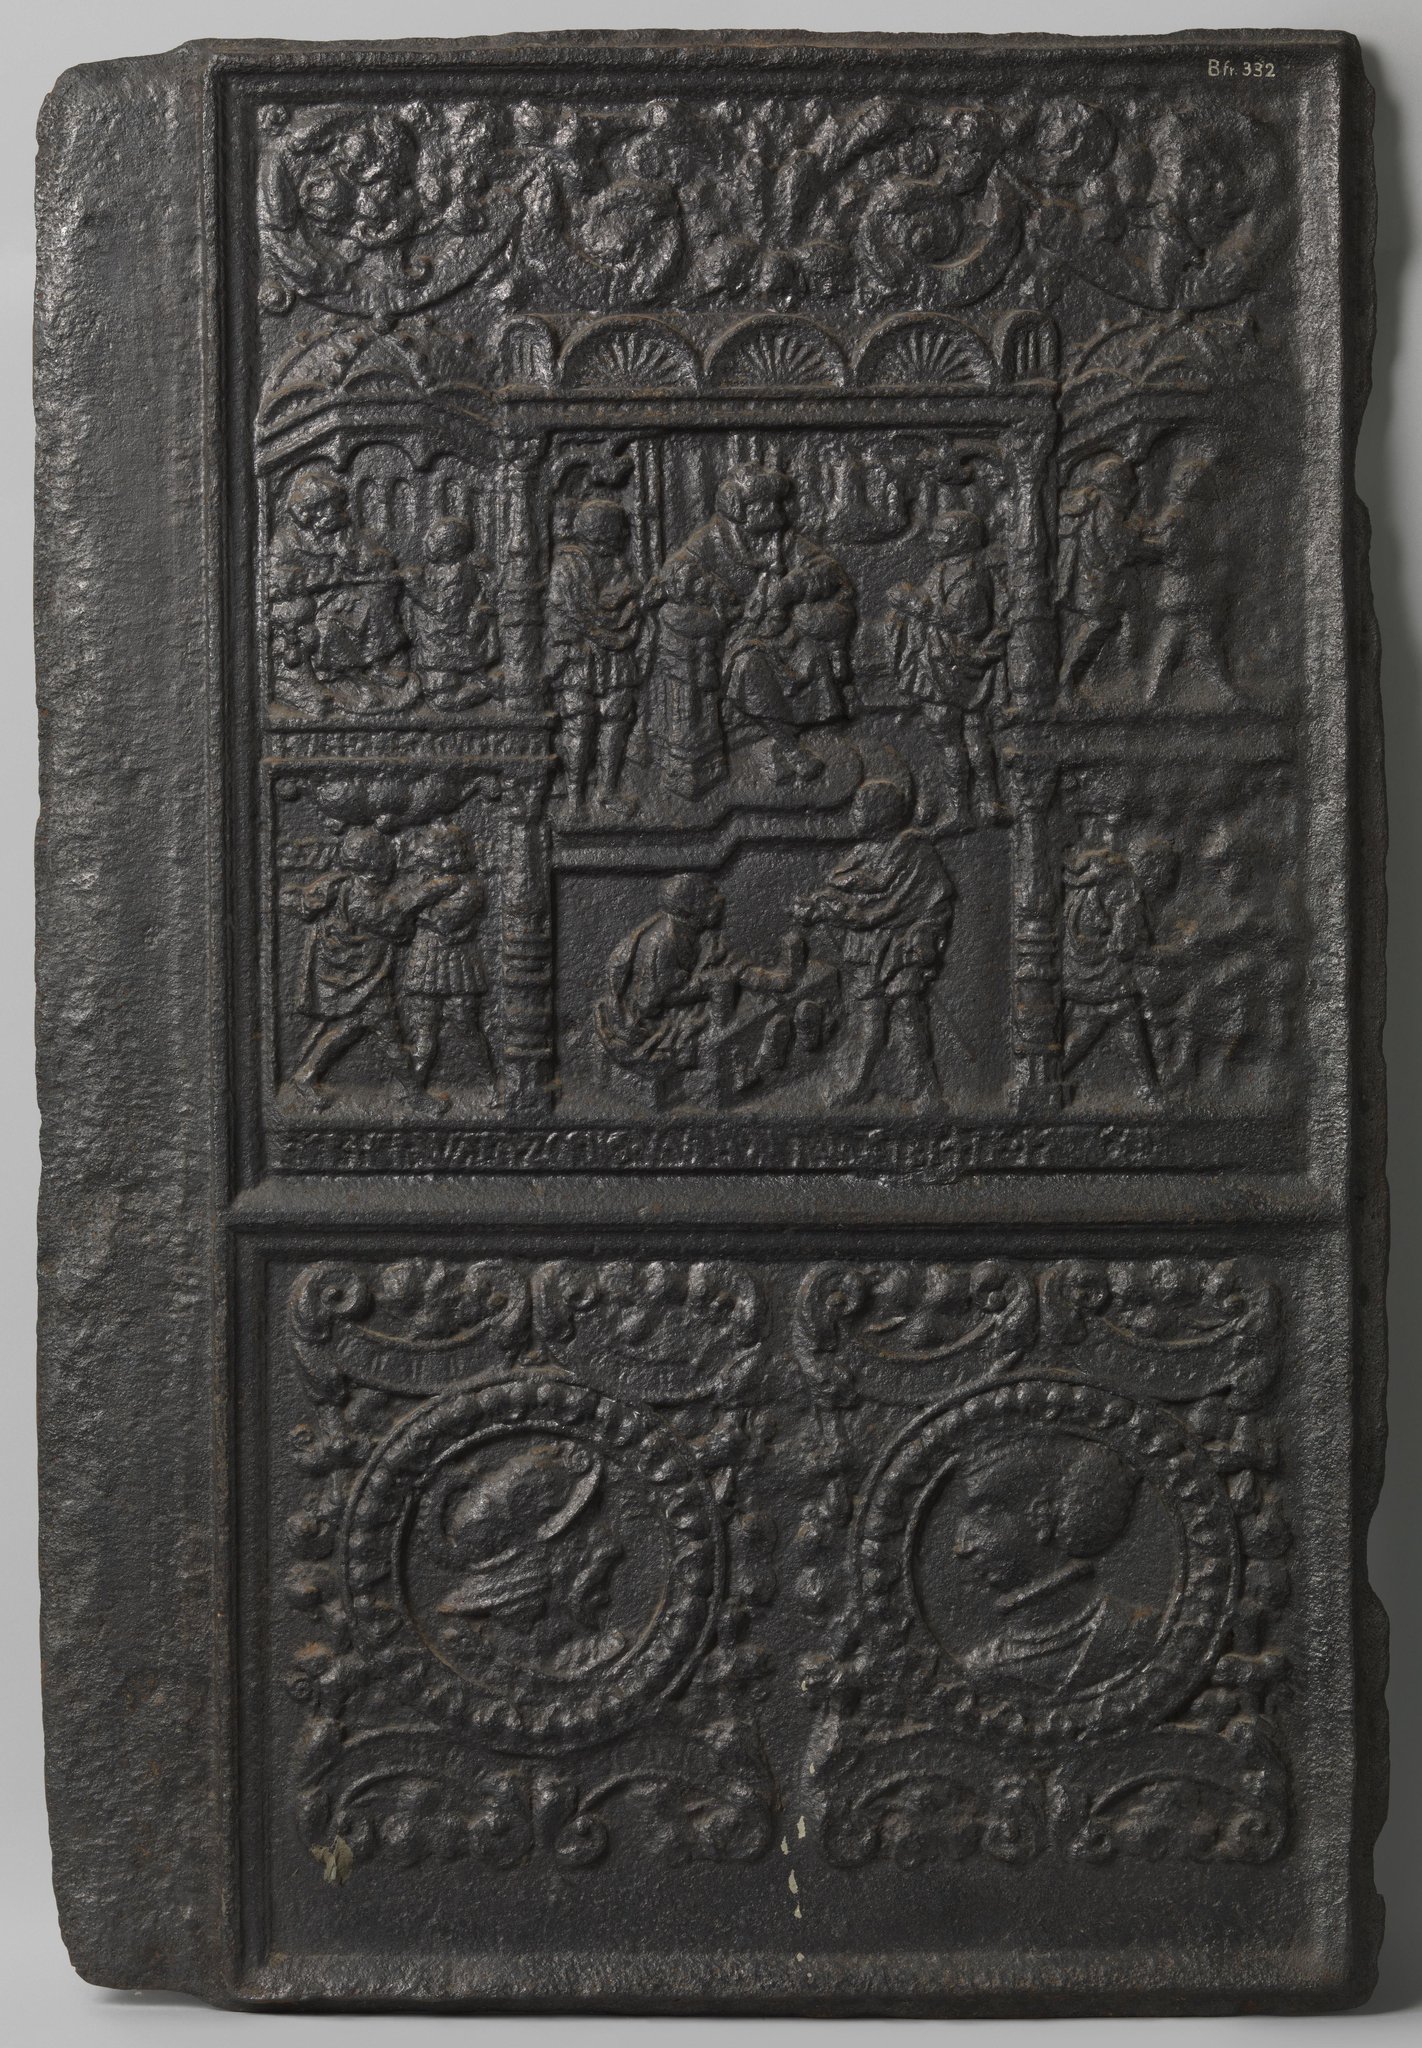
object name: stove plate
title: Kachelplaat met zes taferelen uit het leven van een koning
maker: Anonymous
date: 1550-1600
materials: iron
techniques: casting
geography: germany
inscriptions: inscription, inscription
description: Kachelplaat van gietijzer, verdeeld in twee zones. In de bovenste zone is een geschiedenis in zes taferelen, gescheiden van elkaar door zuilen en in twee zones. In de vlakken links onder en rechts boven zijn telkens twee staande figuren weergegeven. Het middentafereel bovenaan toont een man op een ruime zetel met twee mannen naast hem. Het geheel wordt aan de bovenkant afgesloten met koepels van een paleis. In de onderste zone zijn temidden van rankwerken twee medaillons met bustes te zien: links een man en rechts een vrouw, die elkaar aankijken. Tussen beide zones is een tekstband aangebracht.